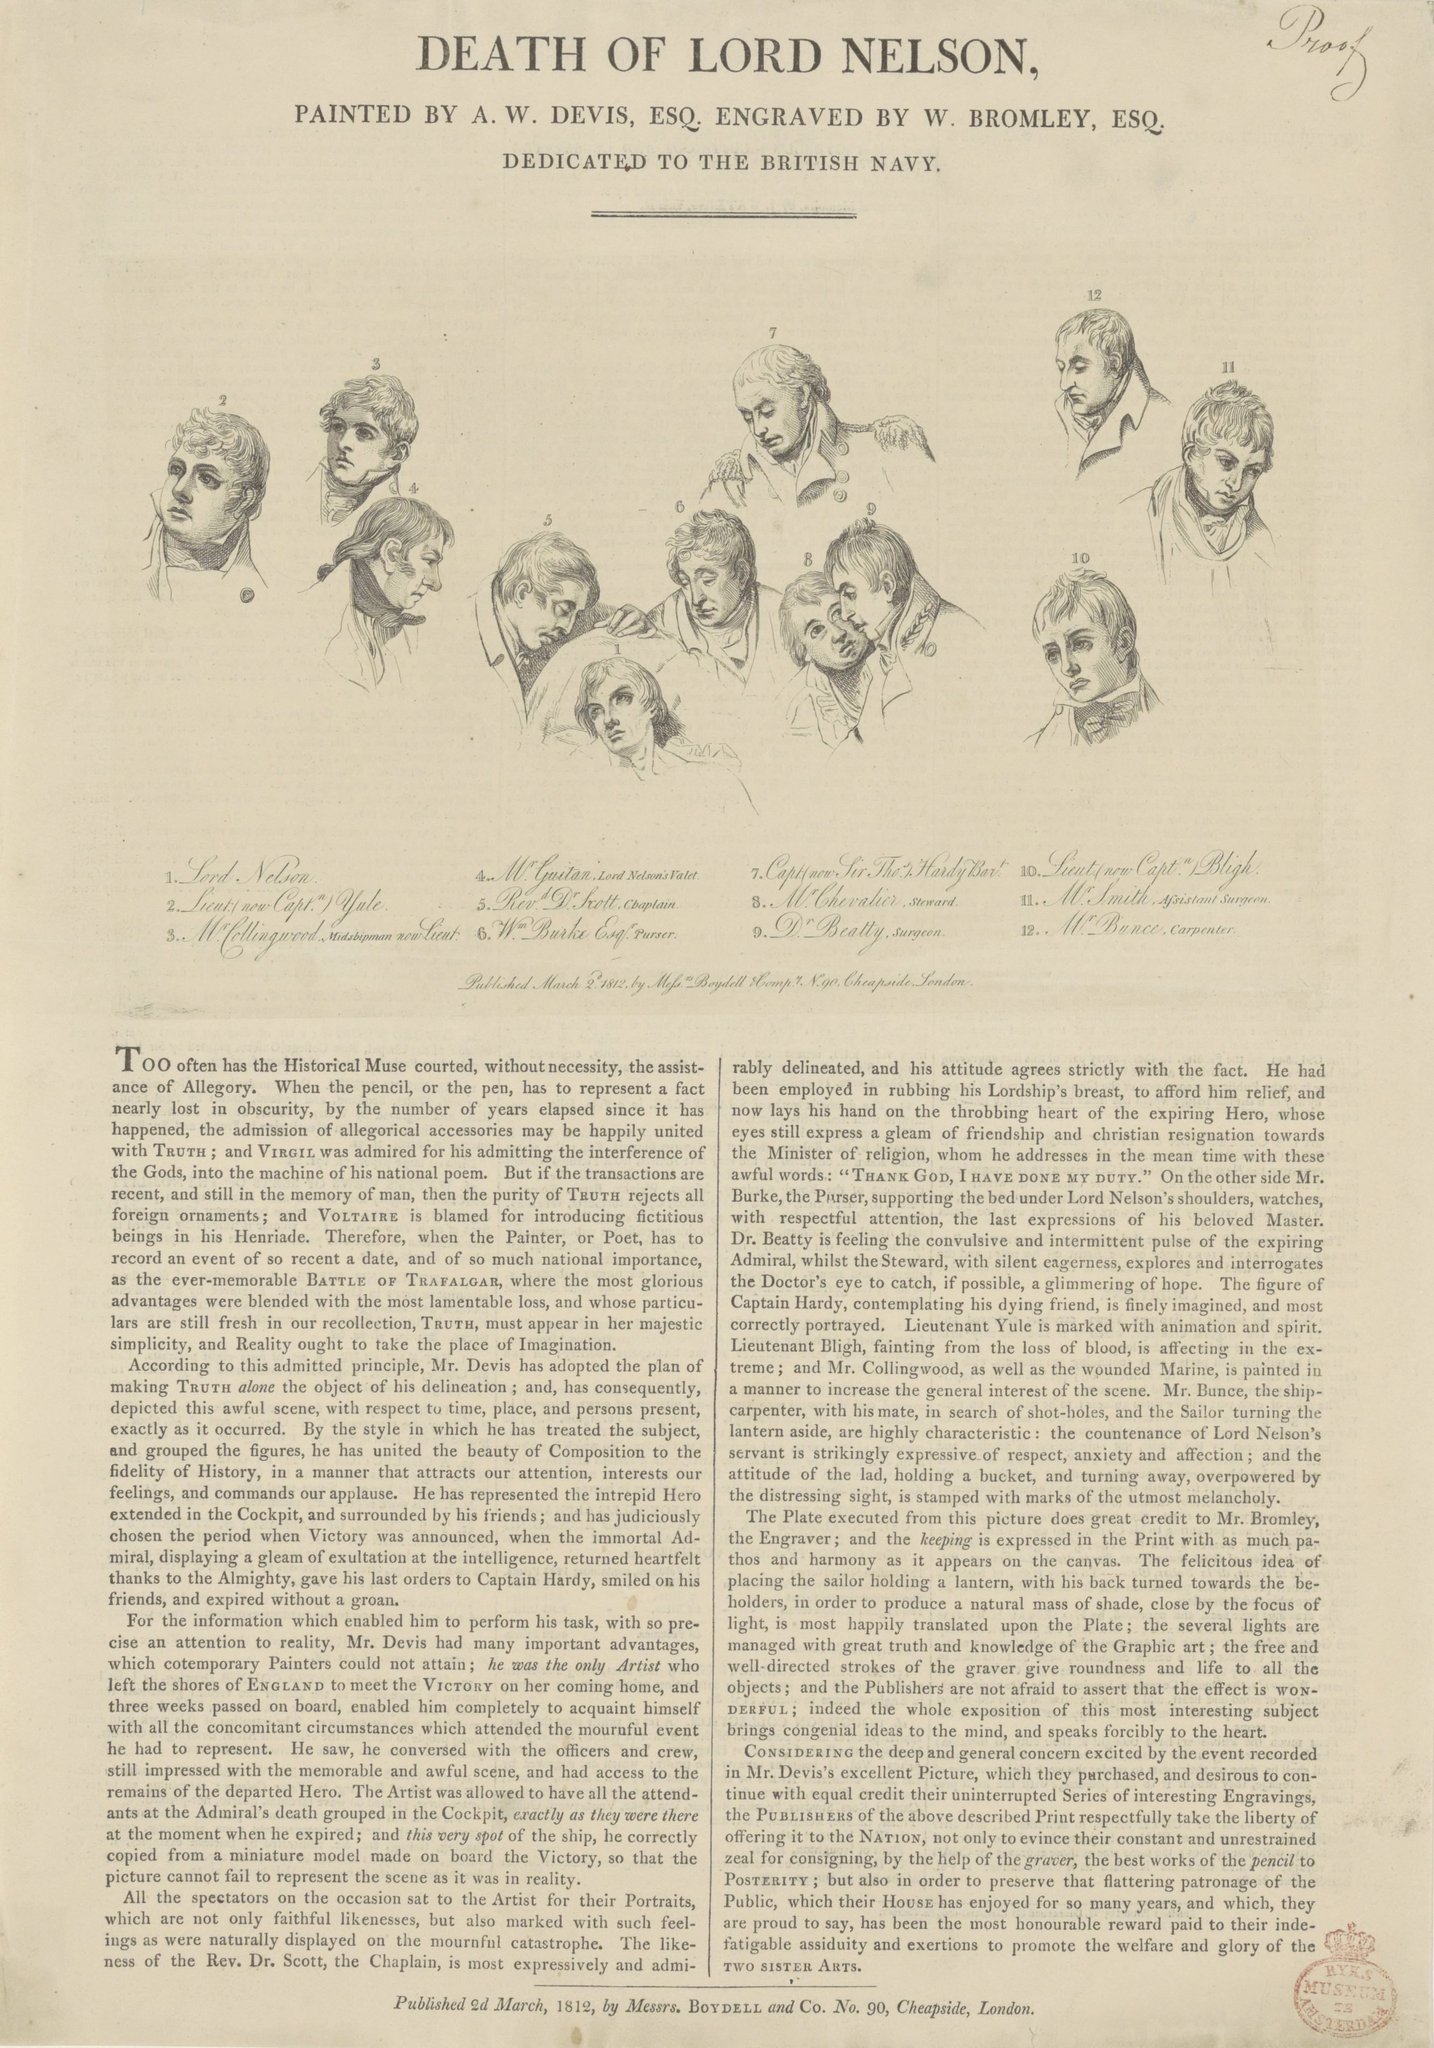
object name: print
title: Figuren op het schilderij De Dood van Lord Nelson door Arthur William Devis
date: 1812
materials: paper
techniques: etching, letterpress printing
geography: england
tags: horatio nelson (hertog van bronte), historical persons, dying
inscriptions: inscription: ‘Proof’, collector's mark: Lugt 12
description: De hoofden van de belangrijkste figuren op het schilderij, genummerd. Op de prent een legenda met de namen van de aanwezigen. Onder de prent een verklarende tekst.